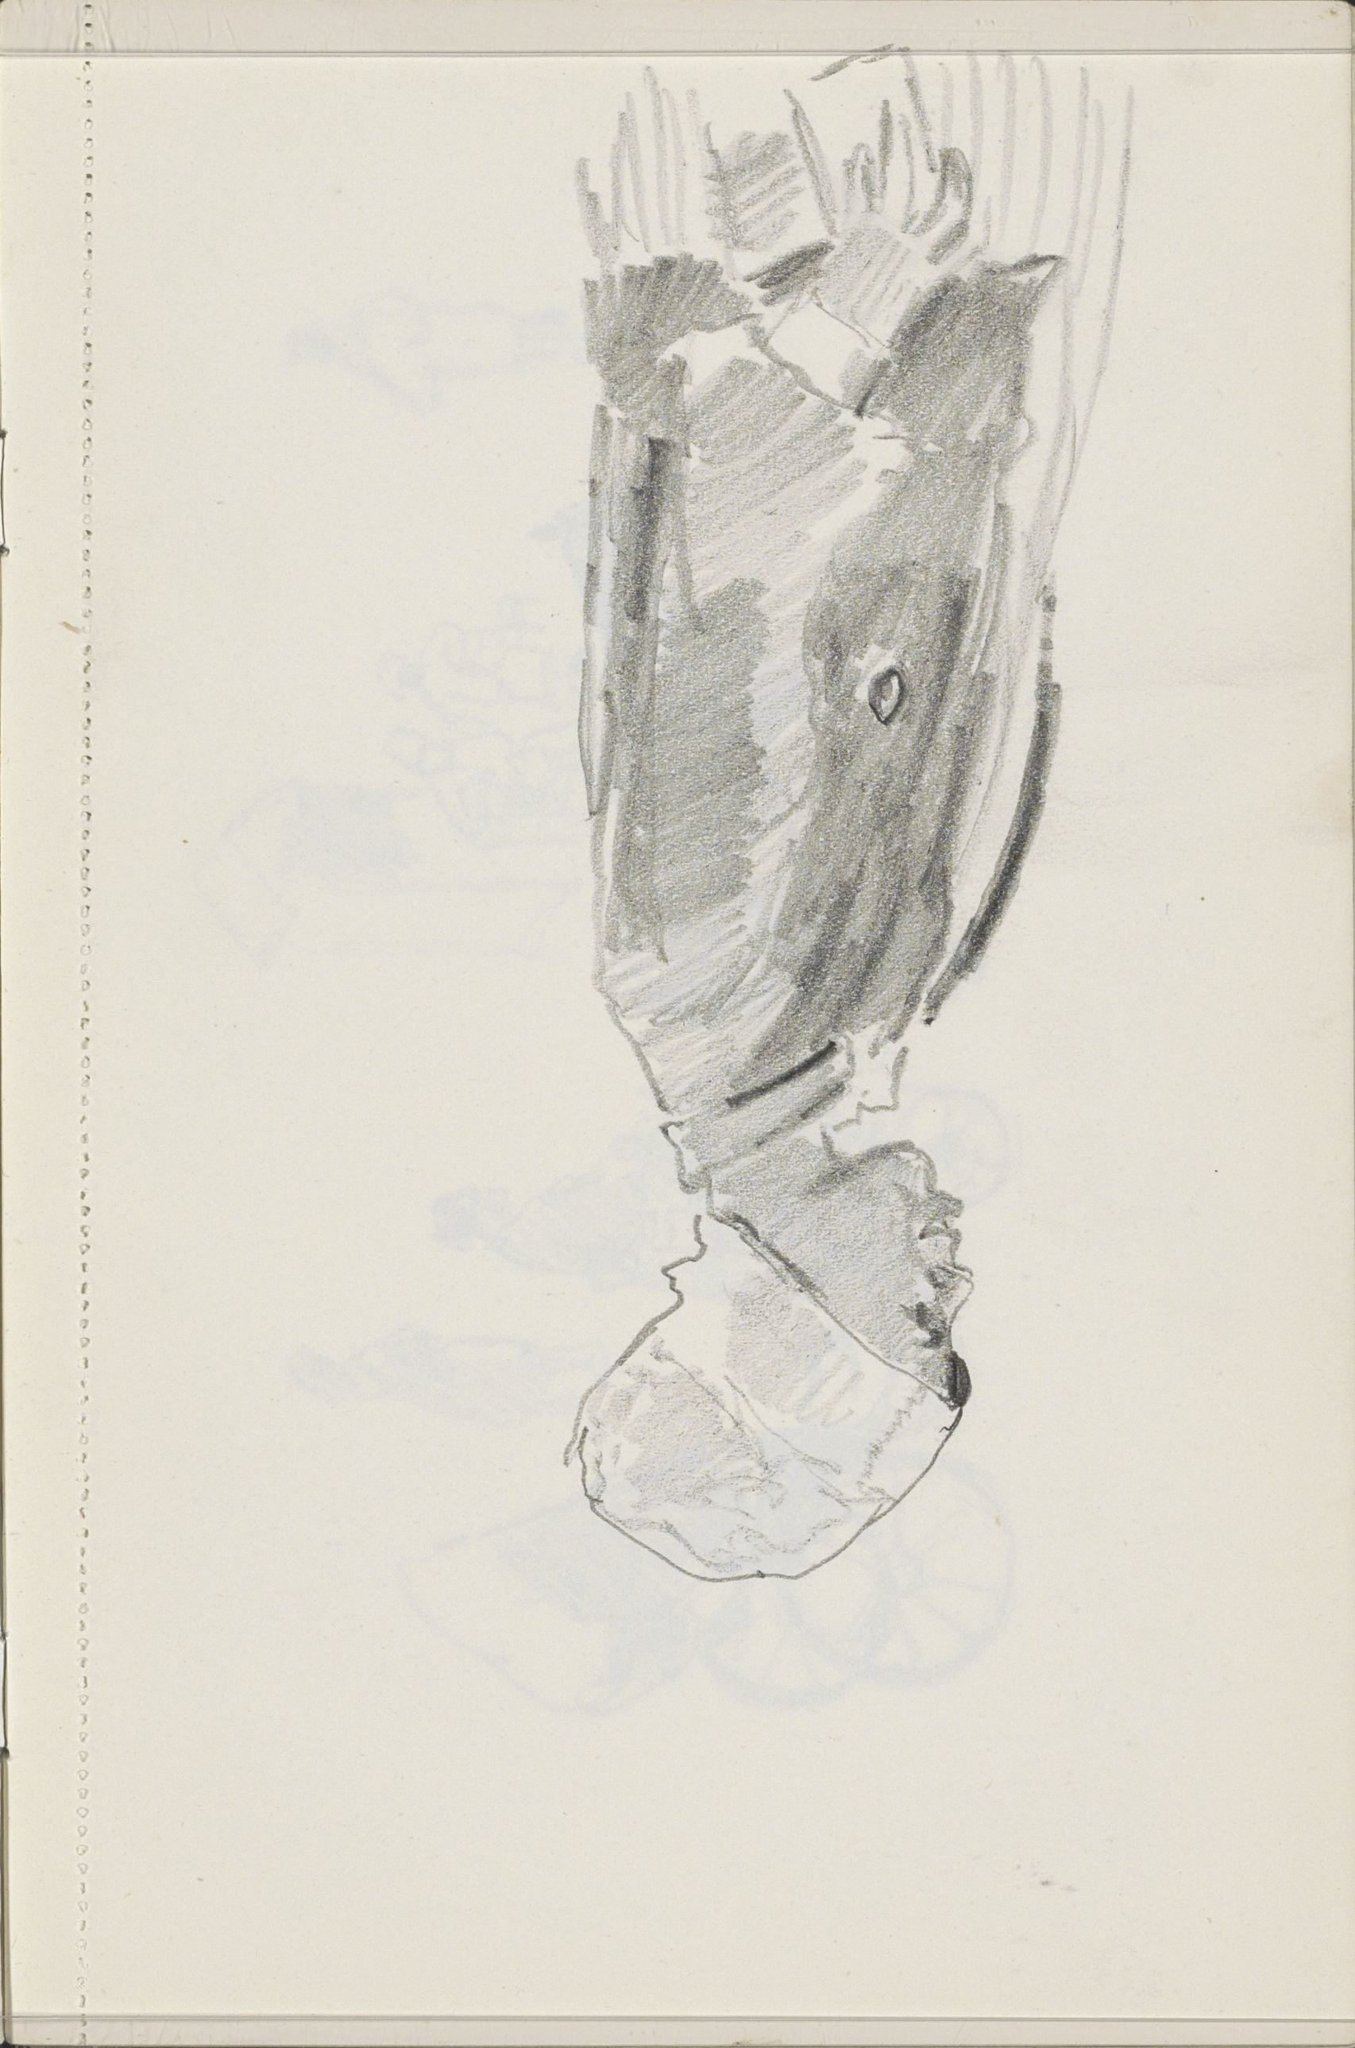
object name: sketchbook leaf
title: Staande jongen in oosters kostuum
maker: cornelis vreedenburgh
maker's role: draughtsman, print maker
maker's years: 1880-1946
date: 1936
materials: paper, pencil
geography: maghreb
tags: boy (child between toddler and youth), marriage, married couple, 'matrimonium'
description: Blad 31 recto uit een schetsboek met 73 bladen.